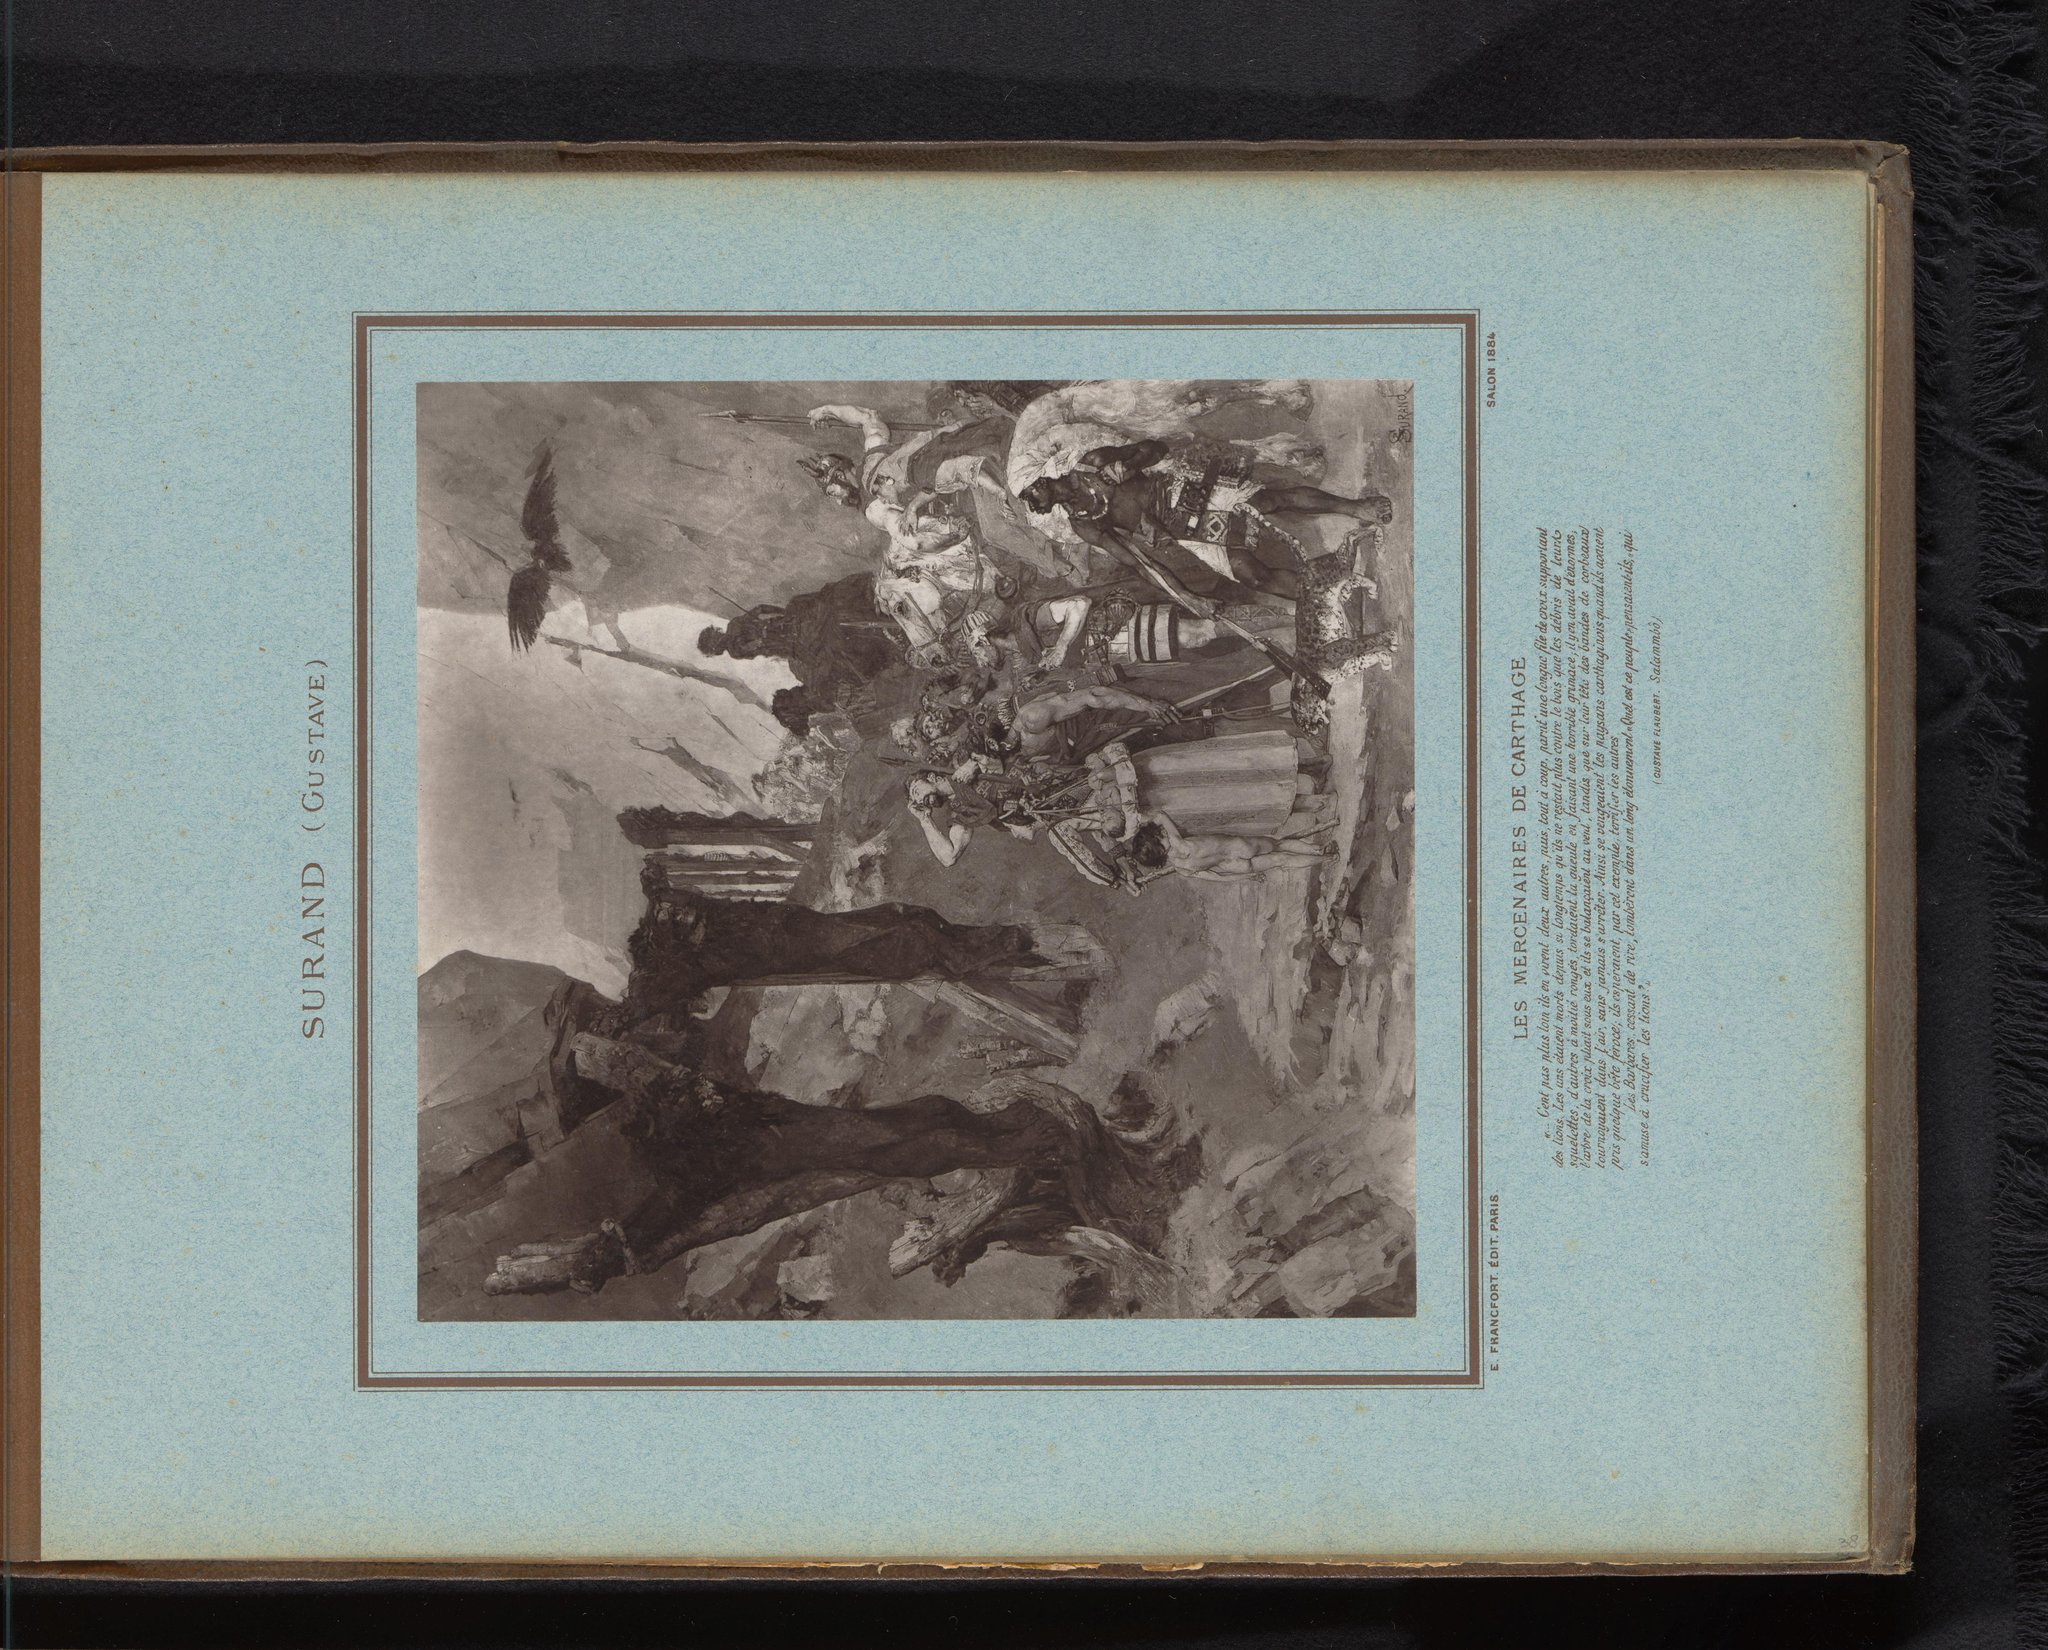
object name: reproduction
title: Les Mercenaires de Carthage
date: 1879-1884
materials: paper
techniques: woodburytype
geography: paris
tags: garrison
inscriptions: inscription: ‘SALON 1884.’, inscription: ‘... Cent plus (...) Flaubert. Salammbó.)’, name: ‘SURAND (Gustave)’